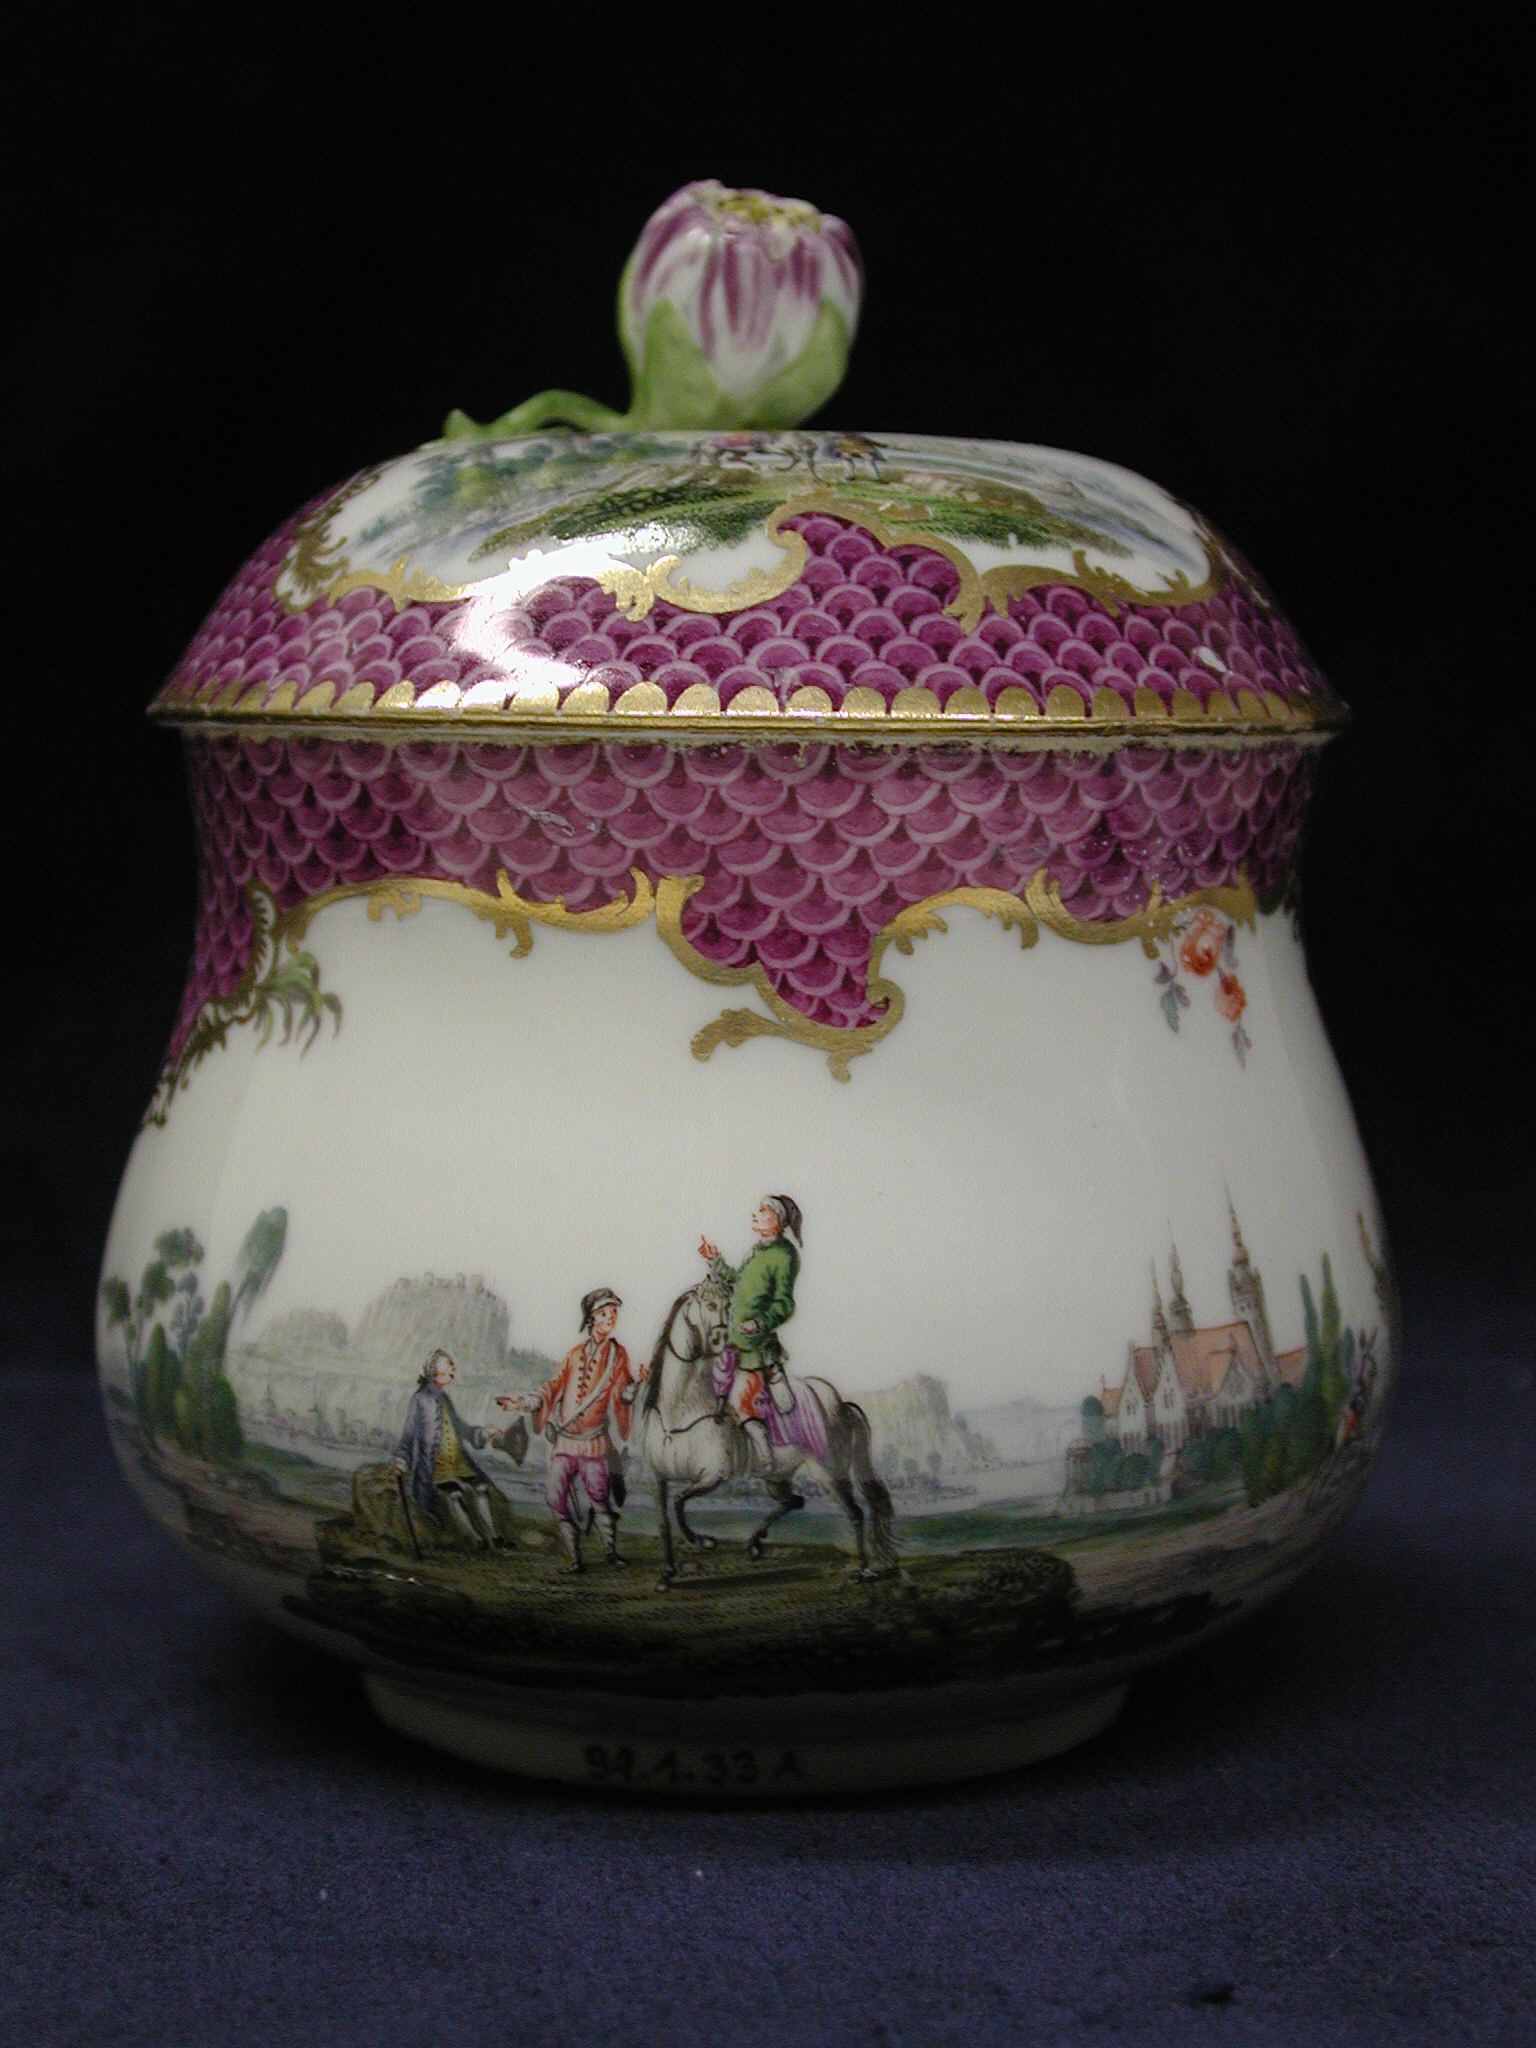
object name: sugar bowl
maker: meissen manufactory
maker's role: manufactory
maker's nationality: german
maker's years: 1710-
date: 1760-1770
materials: hard paste porcelain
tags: men,horses,flowers